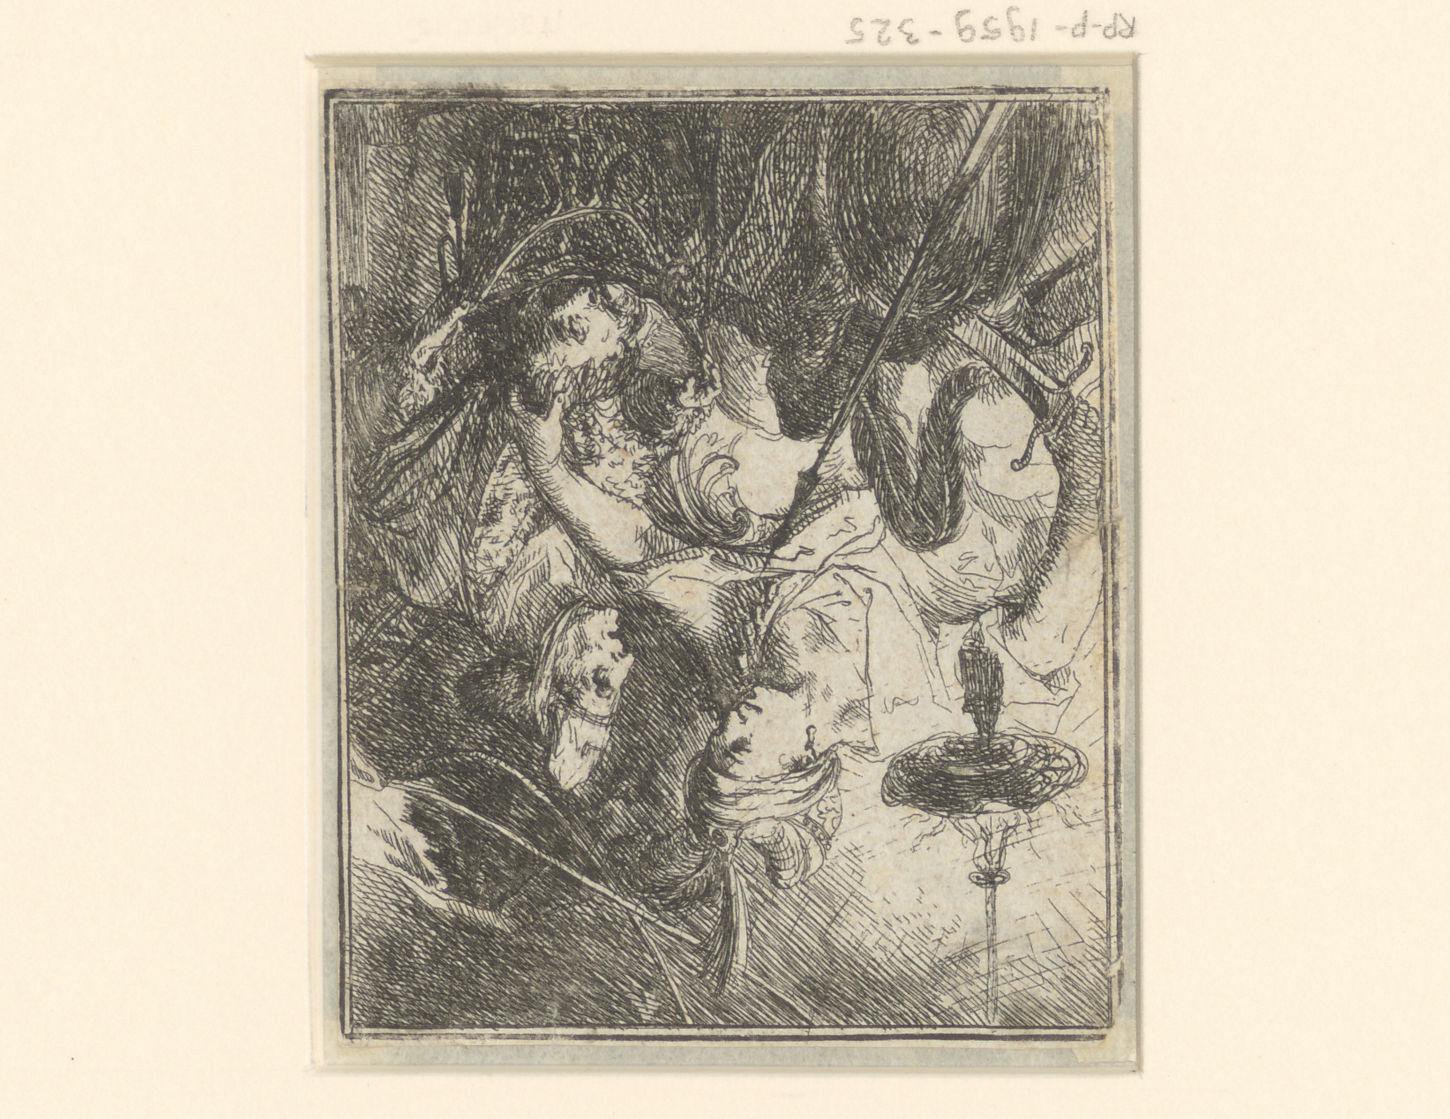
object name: print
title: Judith met het hoofd van Holofernes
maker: johann evangelist holzer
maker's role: print maker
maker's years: 1709-1740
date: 1719-1740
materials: paper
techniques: etching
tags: judith and her maidservant put holofernes' head in a sack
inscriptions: collector's mark: Lugt 2228, collector's mark: Lugt 2760, : ‘LA. De Vries’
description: Met haar linkerhand stopt Judith het hoofd van Holofernes in een zak die door haar bediende wordt opengehouden. Met rechts houdt ze het zwaard vast.